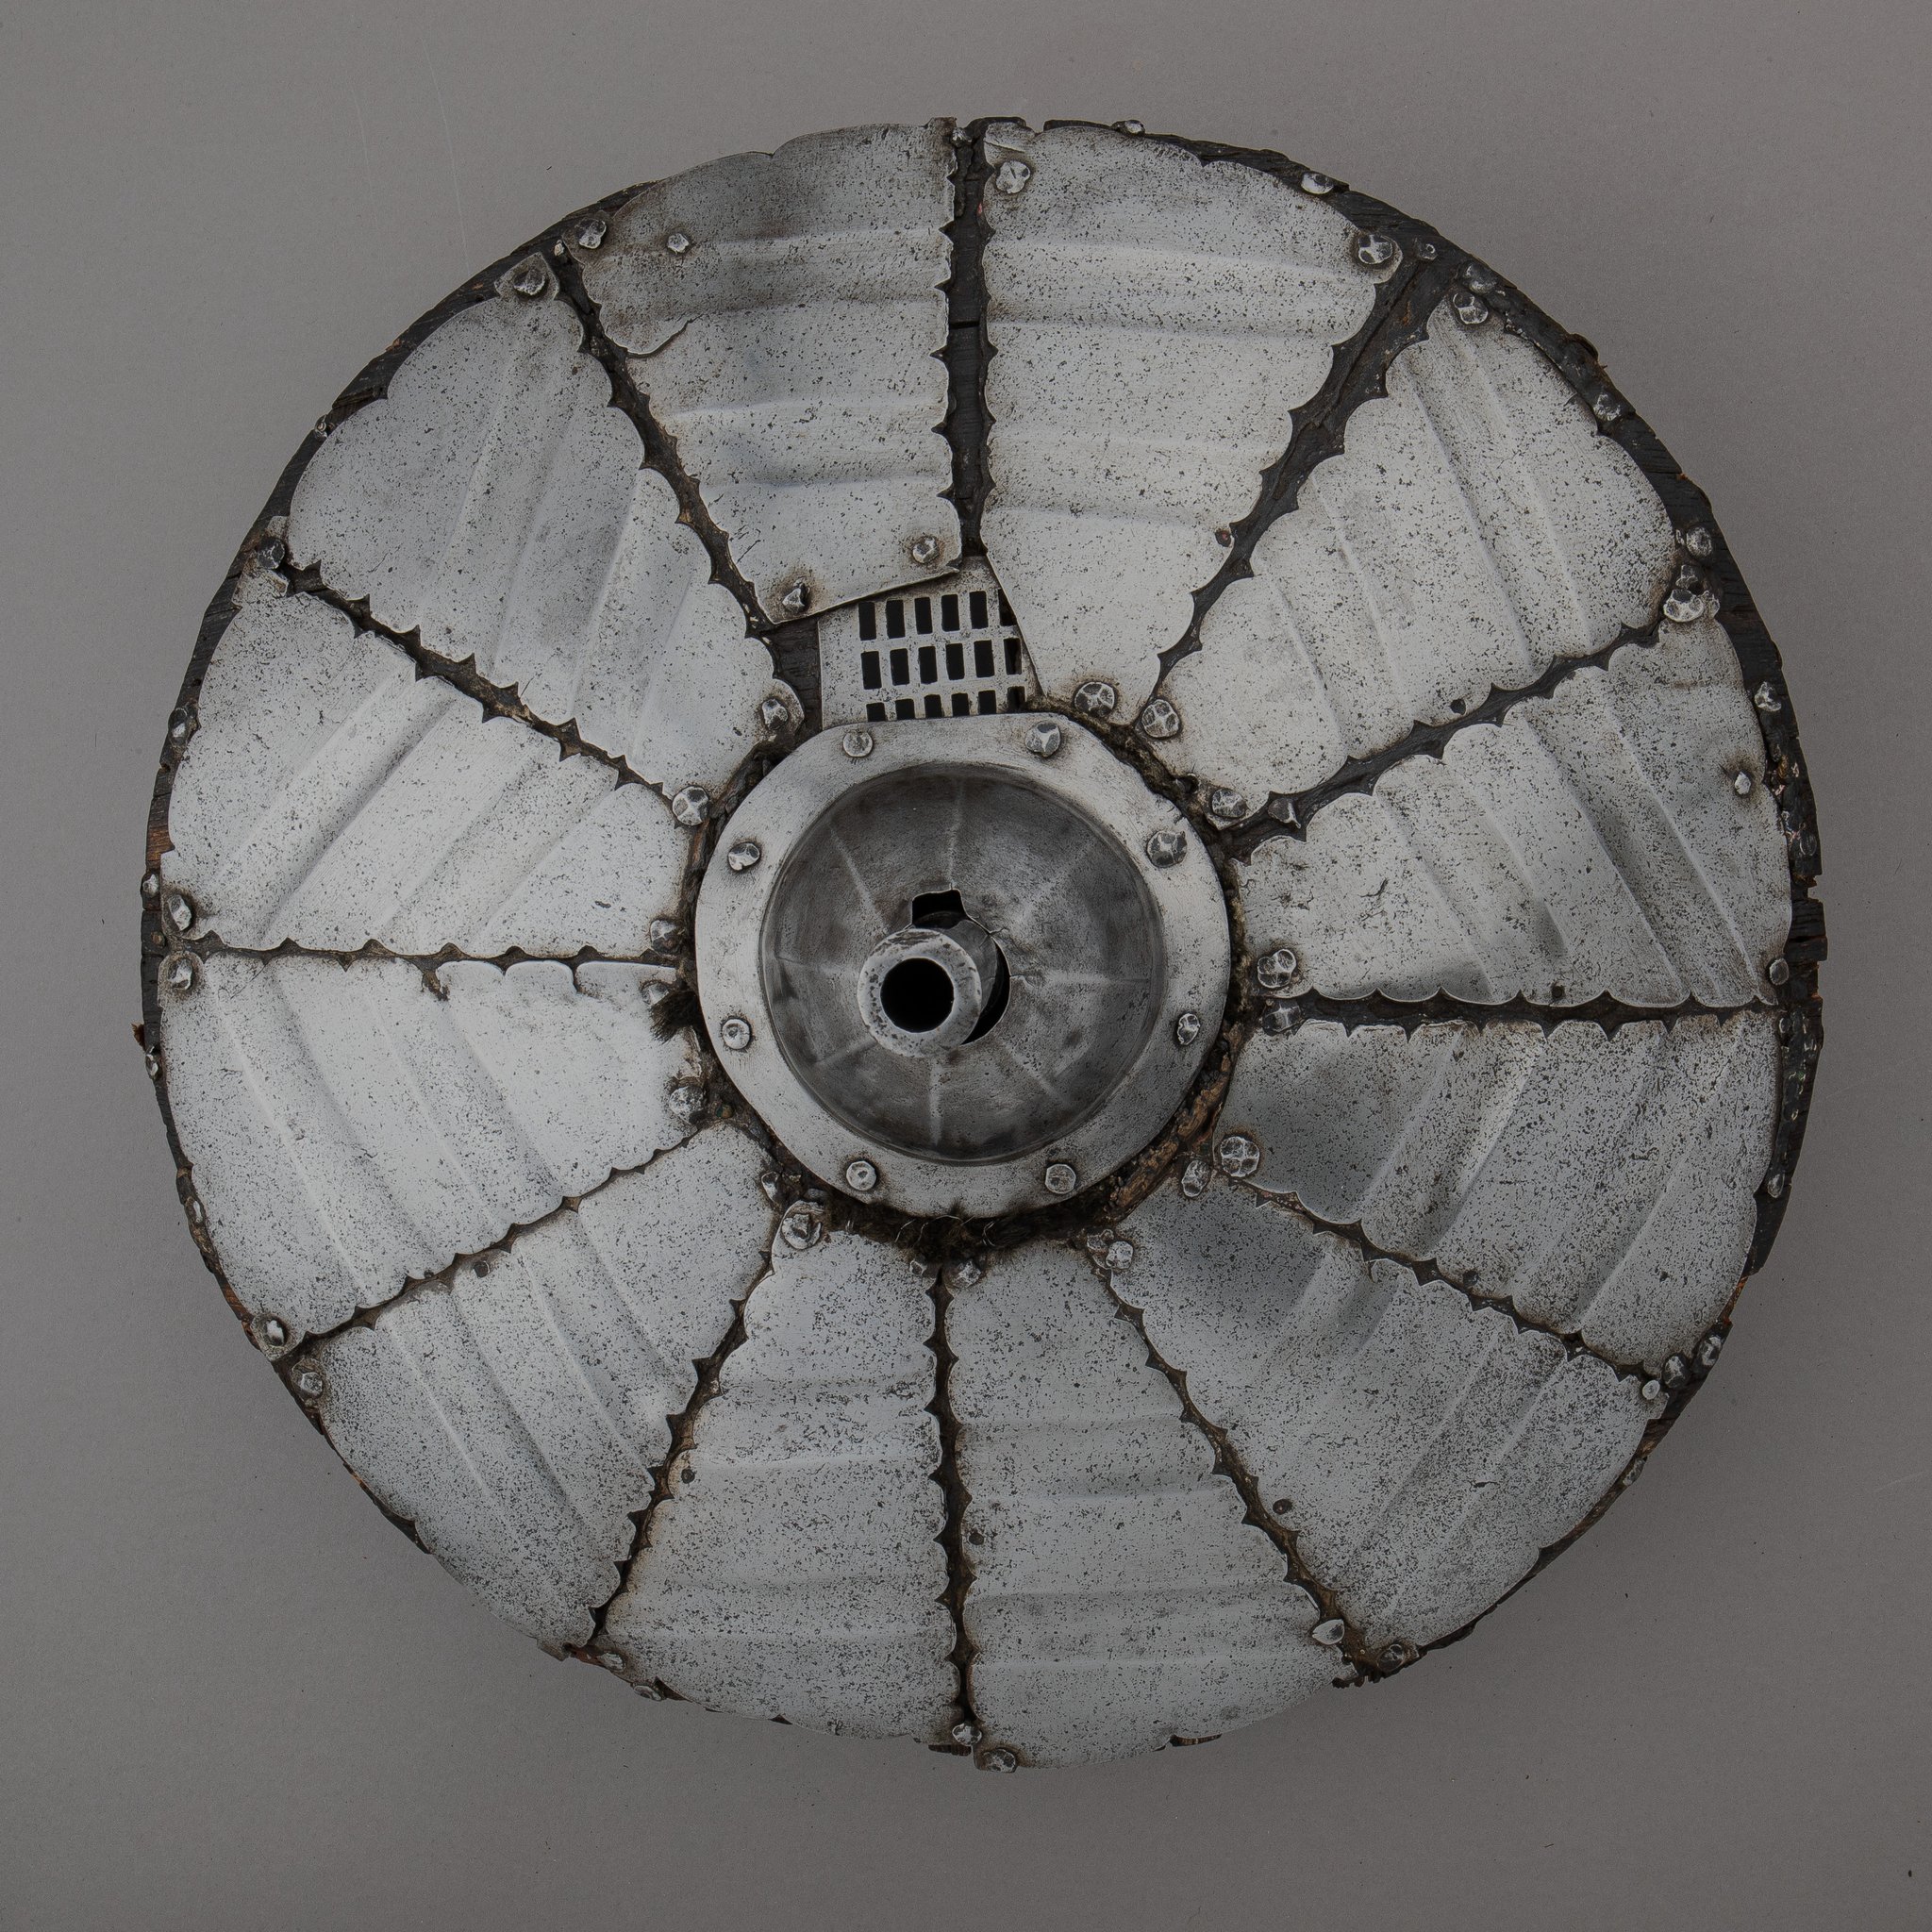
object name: pistol shield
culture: british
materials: iron, steel, textile, wood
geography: england